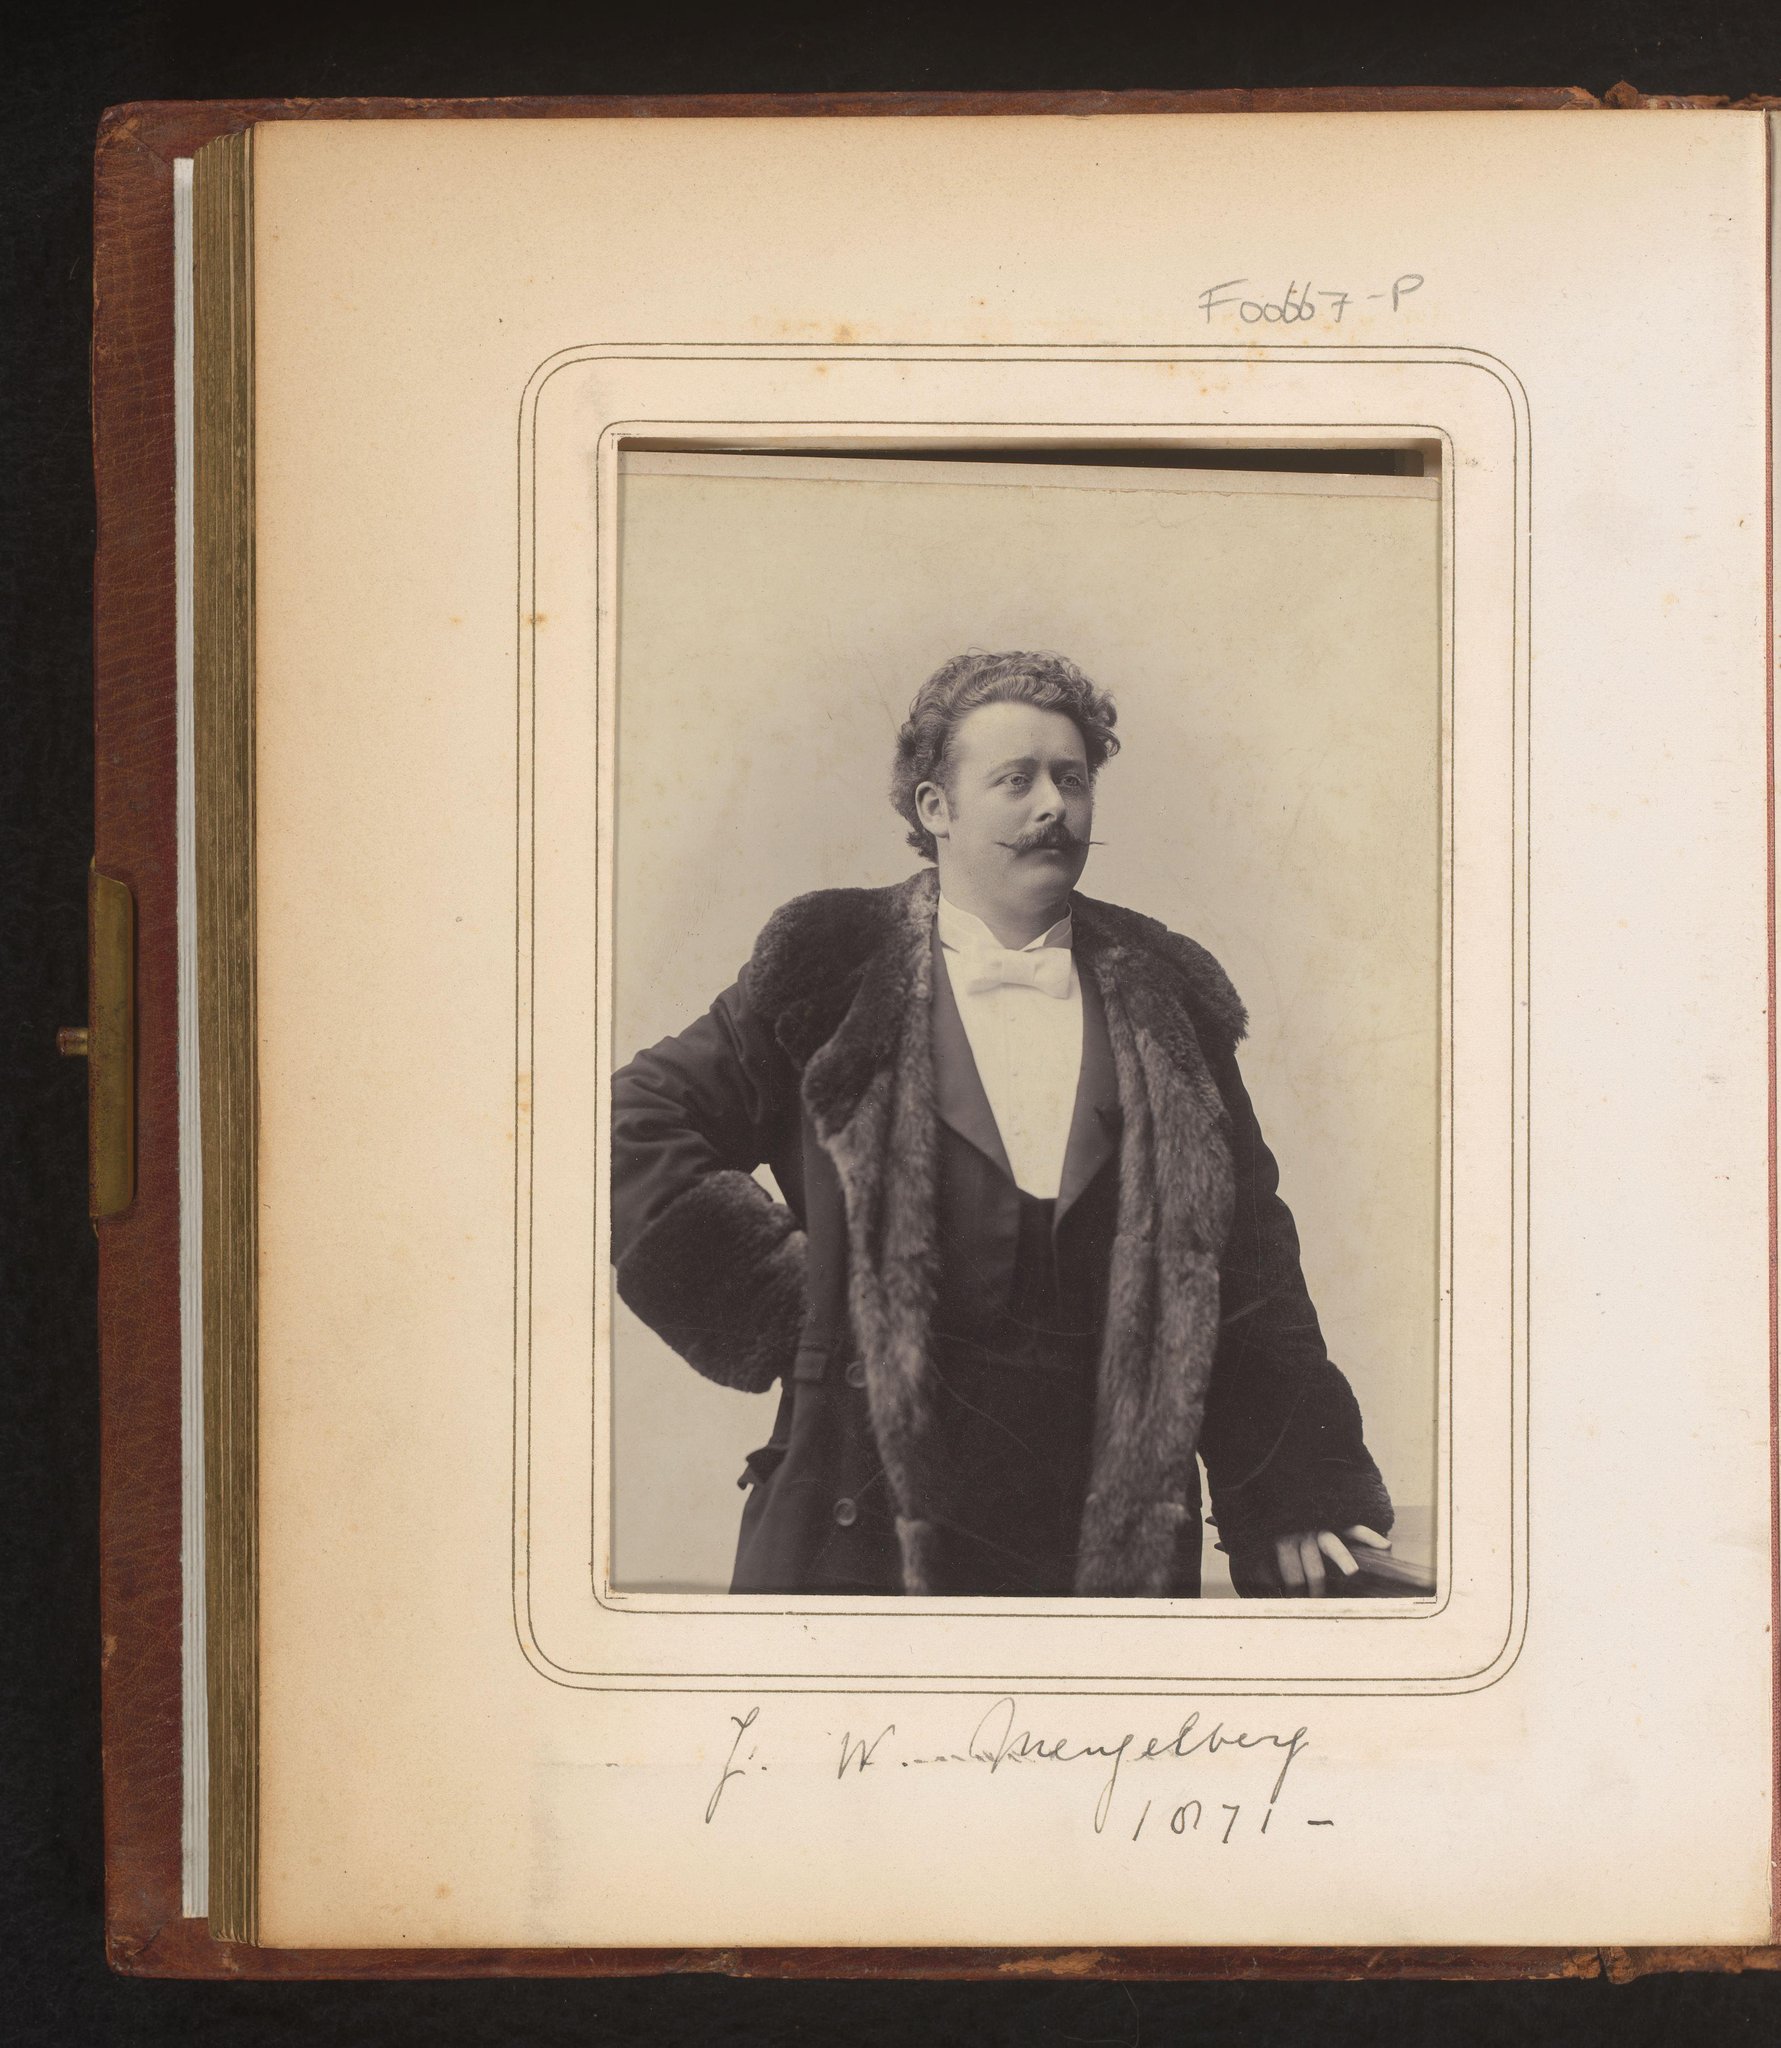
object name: photograph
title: Portret van Willem Mengelberg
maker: herman deutmann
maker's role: fotograaf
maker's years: 1870-1926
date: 1900-1910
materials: cardboard, photographic support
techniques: collodion silver print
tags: utrecht, adult man, historical persons, composer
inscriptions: annotation: ‘J. W. Mengelberg/ 1871 -’